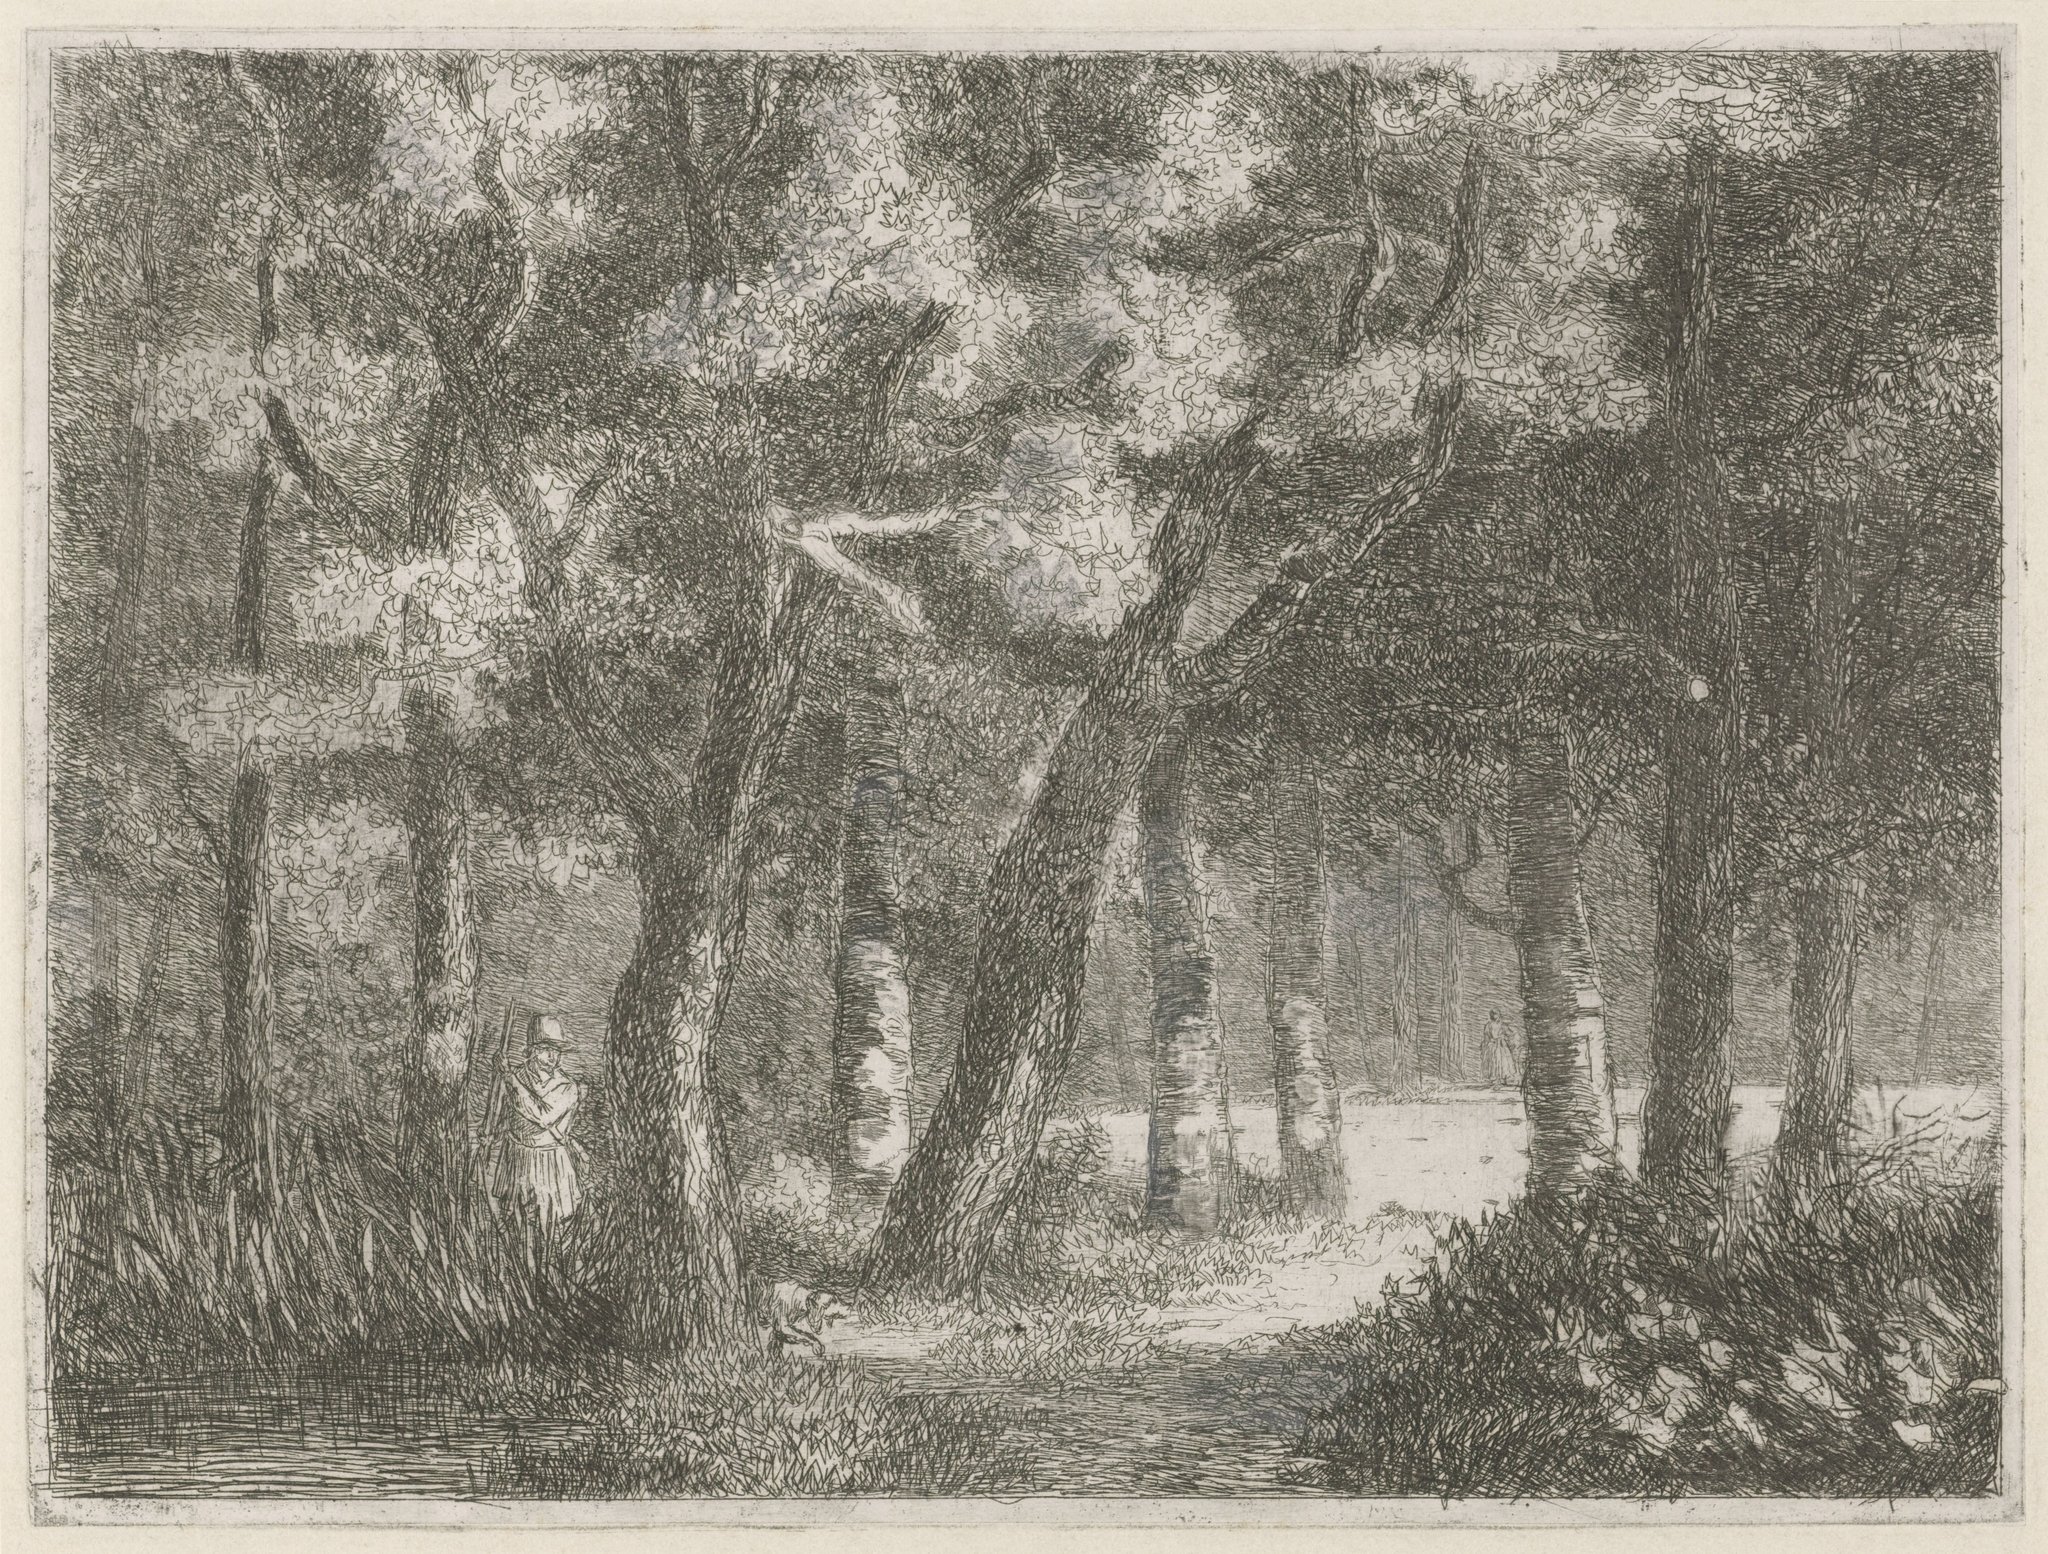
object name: print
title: Jager en zijn hond in het bos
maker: hermanus jan hendrik van rijkelijkhuysen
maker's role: painter, print maker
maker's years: 1813-1883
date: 1823-1883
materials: paper, pencil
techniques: etching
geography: utrecht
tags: hunter, forest, wood, dog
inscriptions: collector's mark: Lugt 2228